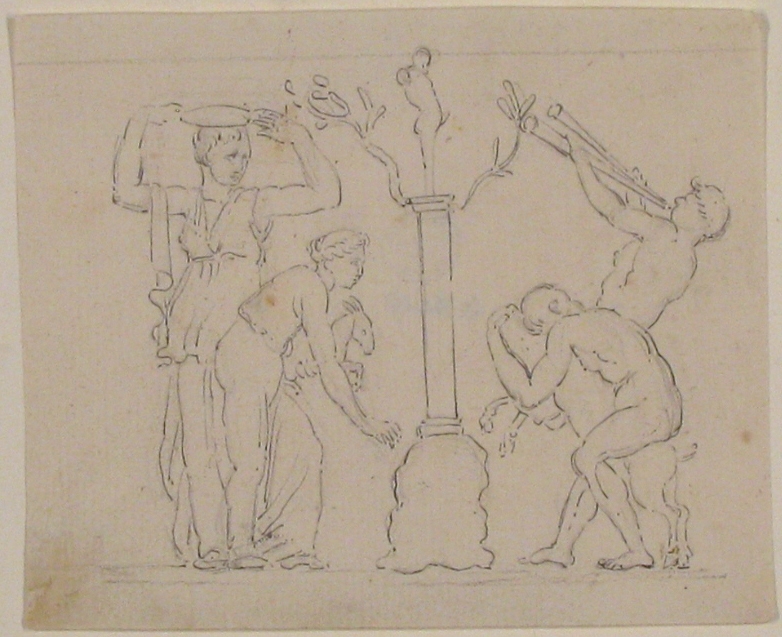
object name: drawing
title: Scene of Sacrifice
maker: anonymous, french, 18th century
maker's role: artist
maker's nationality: french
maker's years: 1700-1800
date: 1701-1800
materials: graphite, ink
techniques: pen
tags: musical instruments,men,women,goats